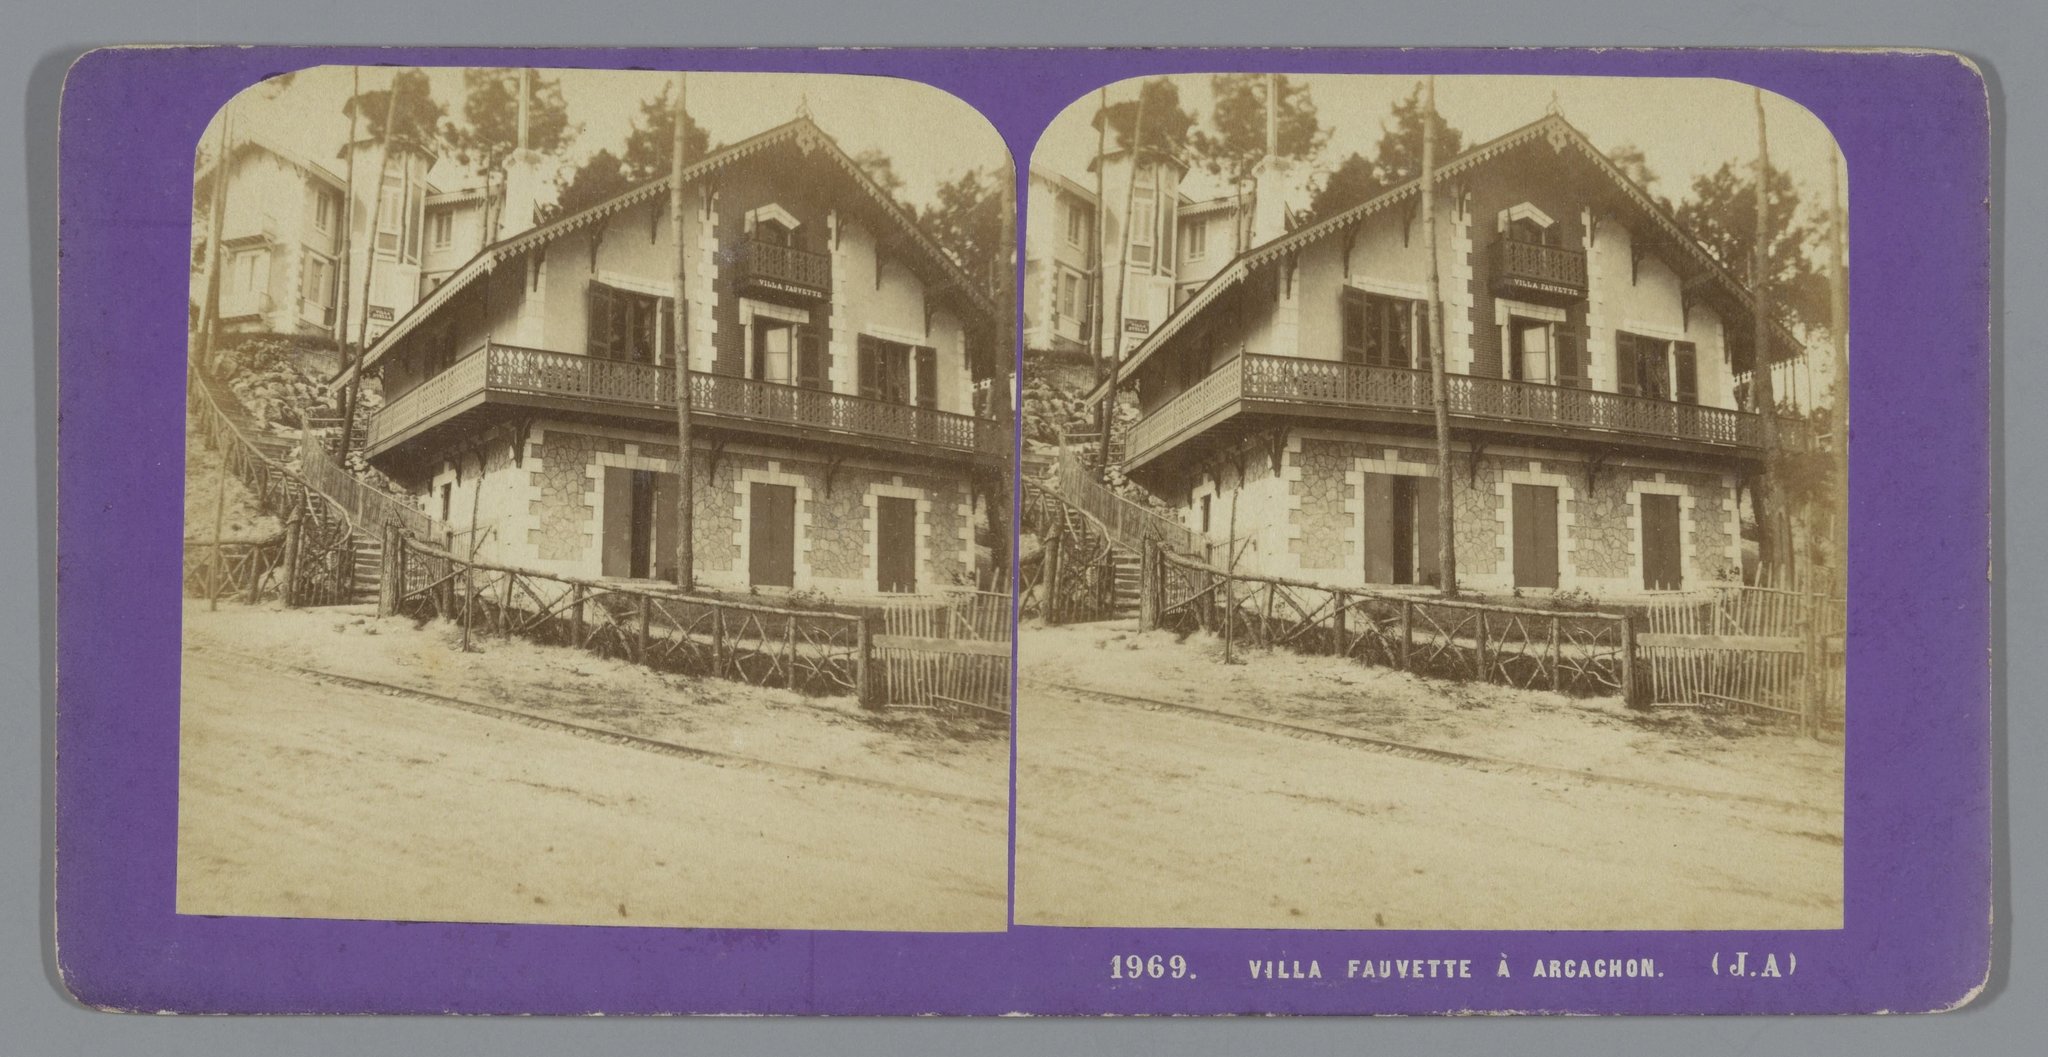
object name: stereograph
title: Villa Fauvette à Arcachon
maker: jean andrieu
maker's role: fotograaf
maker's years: 1816-1872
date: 1862-1876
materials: cardboard, photographic support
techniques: albumen print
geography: arcachon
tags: rural housing, e.g. country-house, villa, cottage, façade (of house or building)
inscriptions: number: ‘1969’